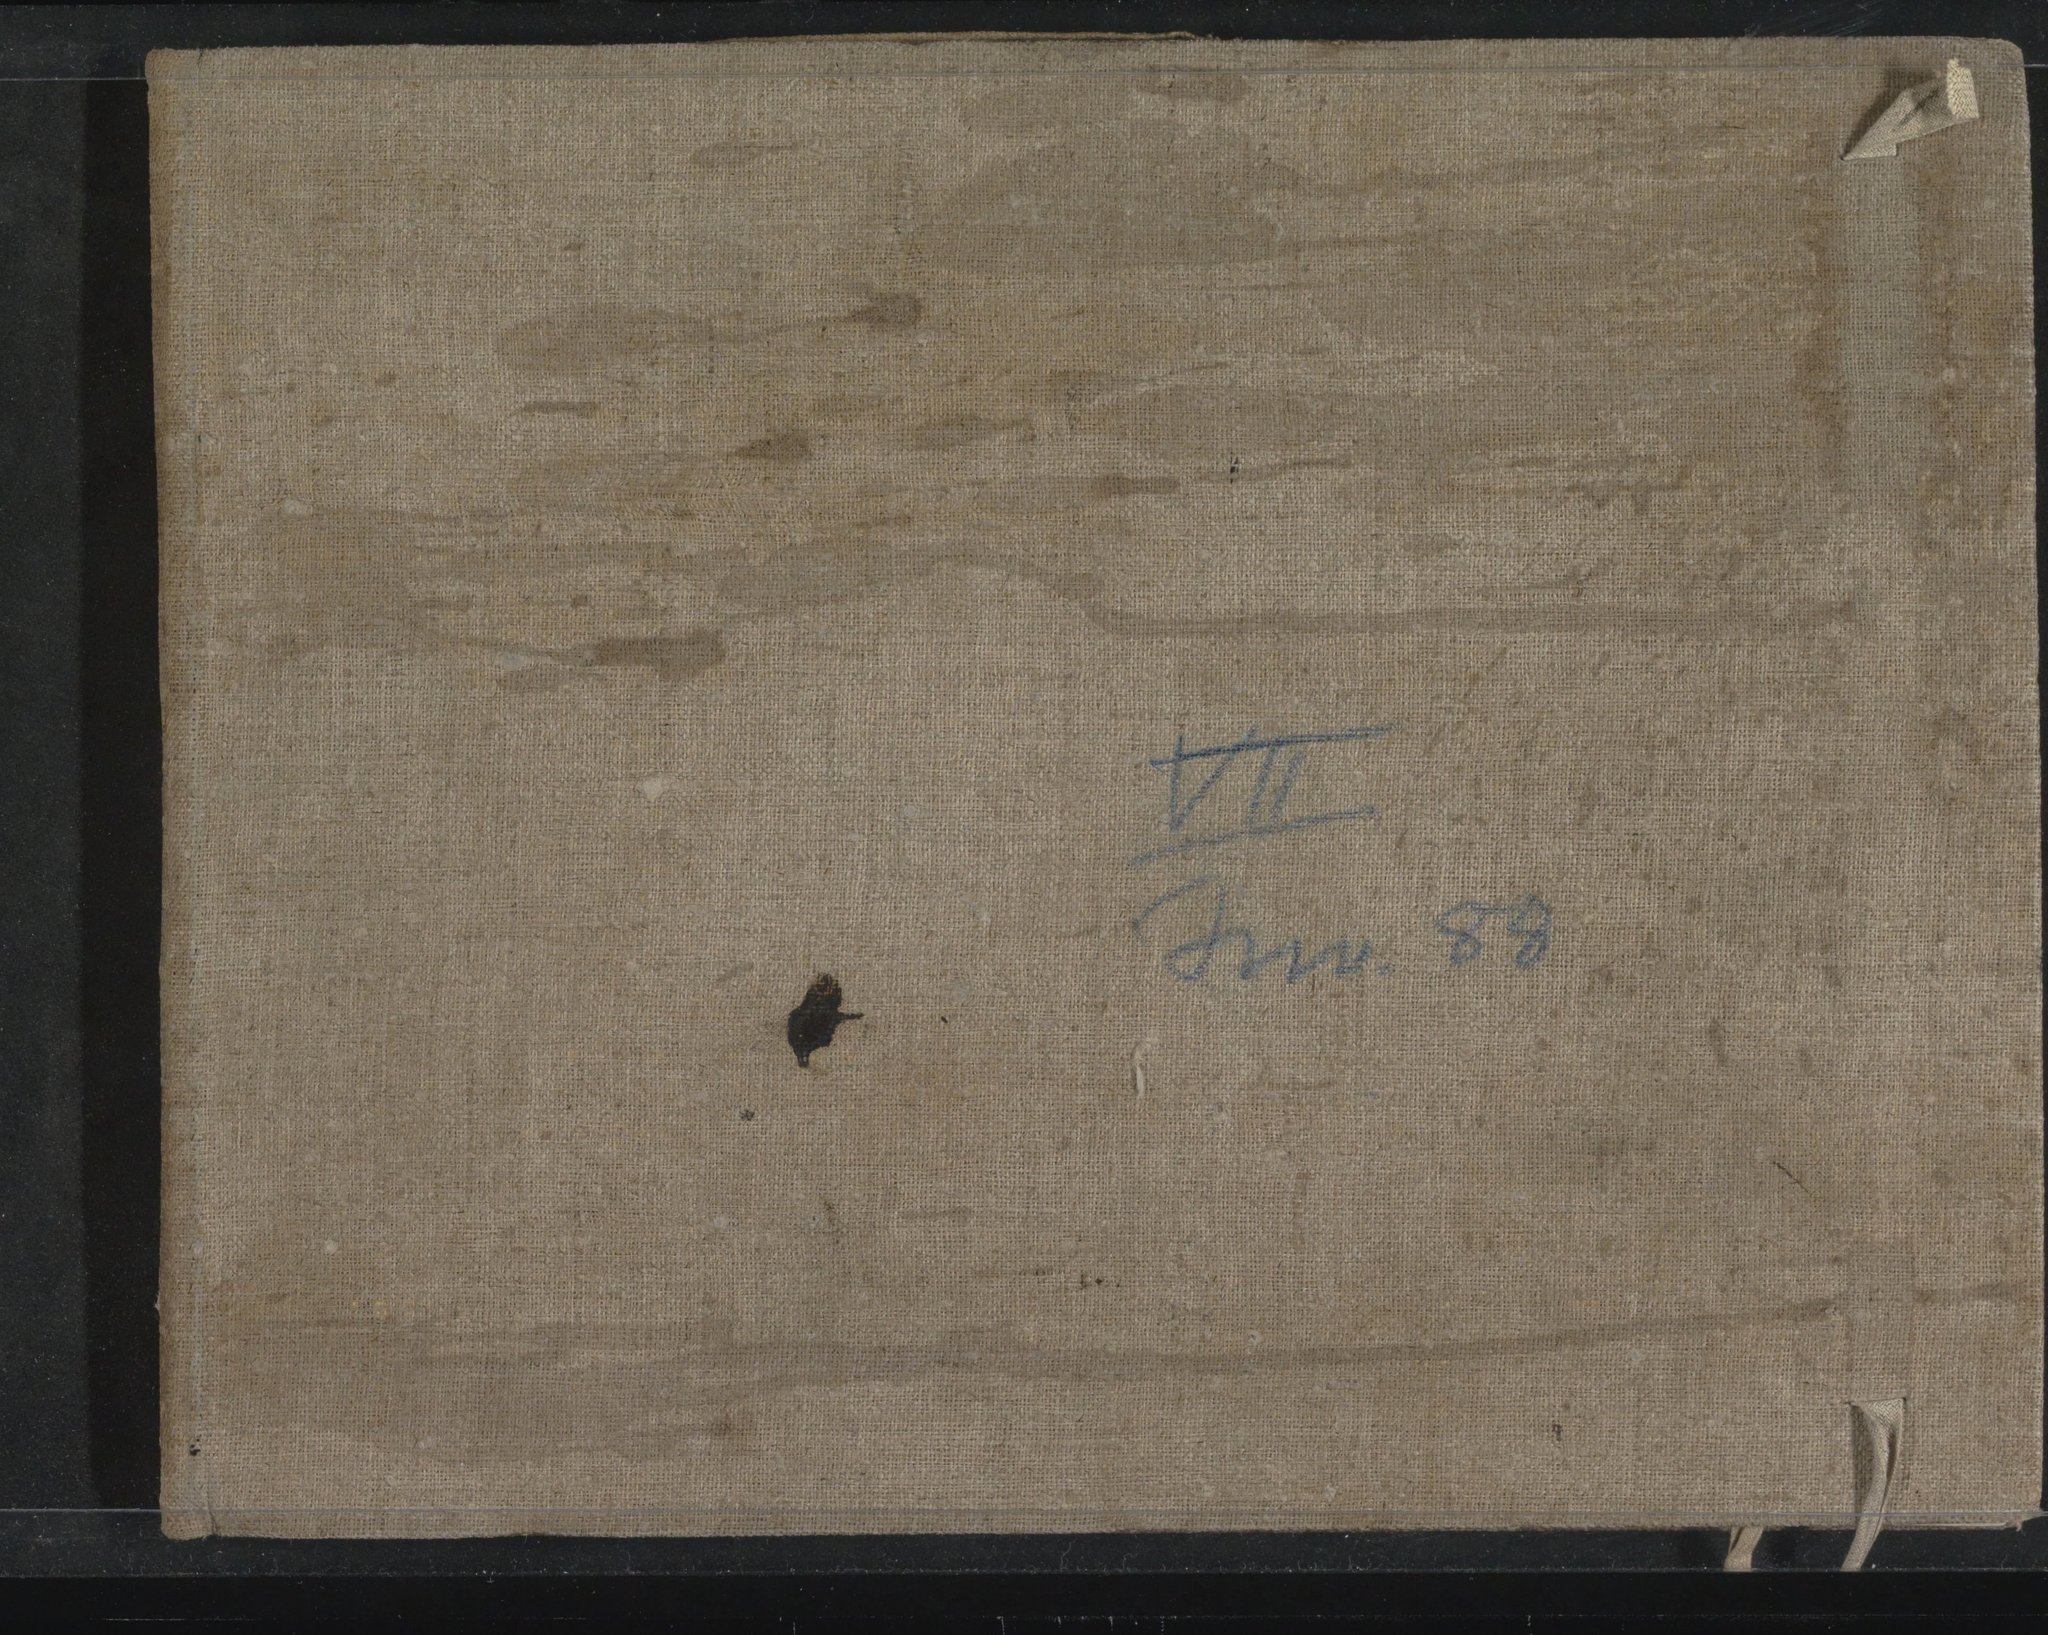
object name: sketchbook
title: Schetsboek VII met 26 bladen met figuurstudies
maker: isaac israels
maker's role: draughtsman, painter, print maker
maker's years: 1865-1934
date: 1875-1934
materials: cardboard, chalk, linen, paper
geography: the hague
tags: adult man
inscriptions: collector's mark: Lugt 2228, label: ‘London & Birmingham. / Established 50 years. / Müller & Co. / Manufacturers and importers / 62, High Holborn, 430, Strand [...]’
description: Bladen 3(V), 4(R), 5(V), 6(R), 9(R), 15(V), 16(R), 19(R), 22(V), 23(R) zijn blanco en daarom niet beschreven.